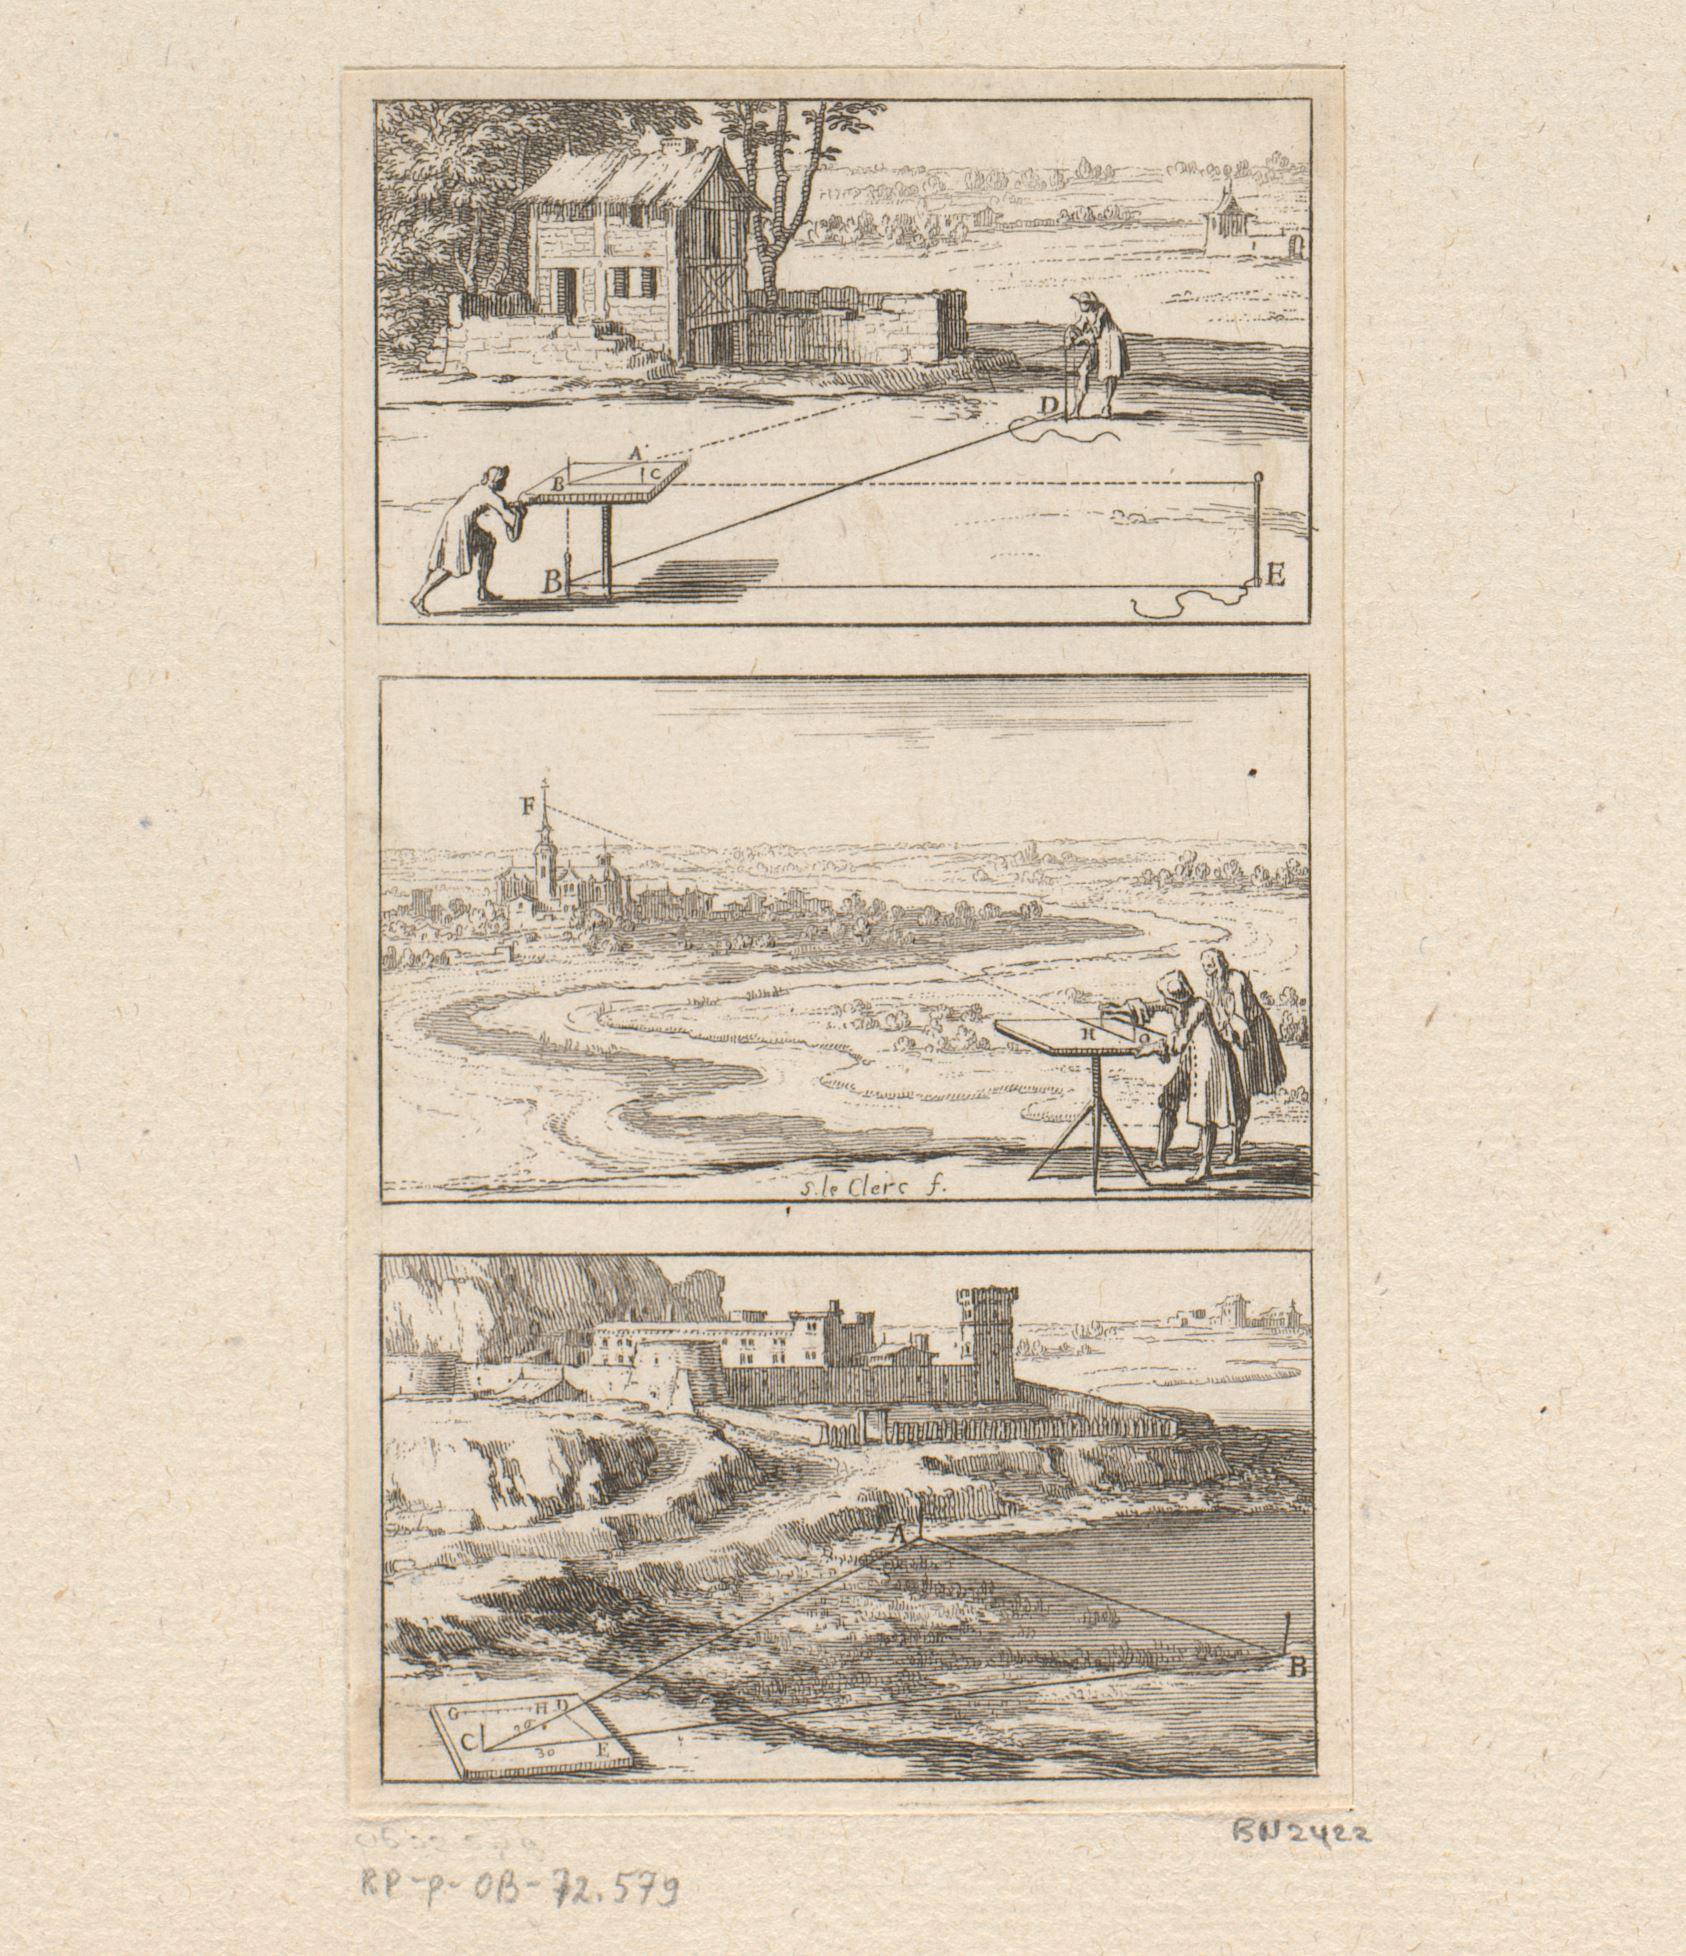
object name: print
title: Gebruik van de halve cirkel geïllustreerd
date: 1690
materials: paper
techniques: etching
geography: paris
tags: planimetry, geometry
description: Prent uit: Leclerc, Sébastien. Traité de géométrie (...). Parijs: Jean Jombert, 1690.